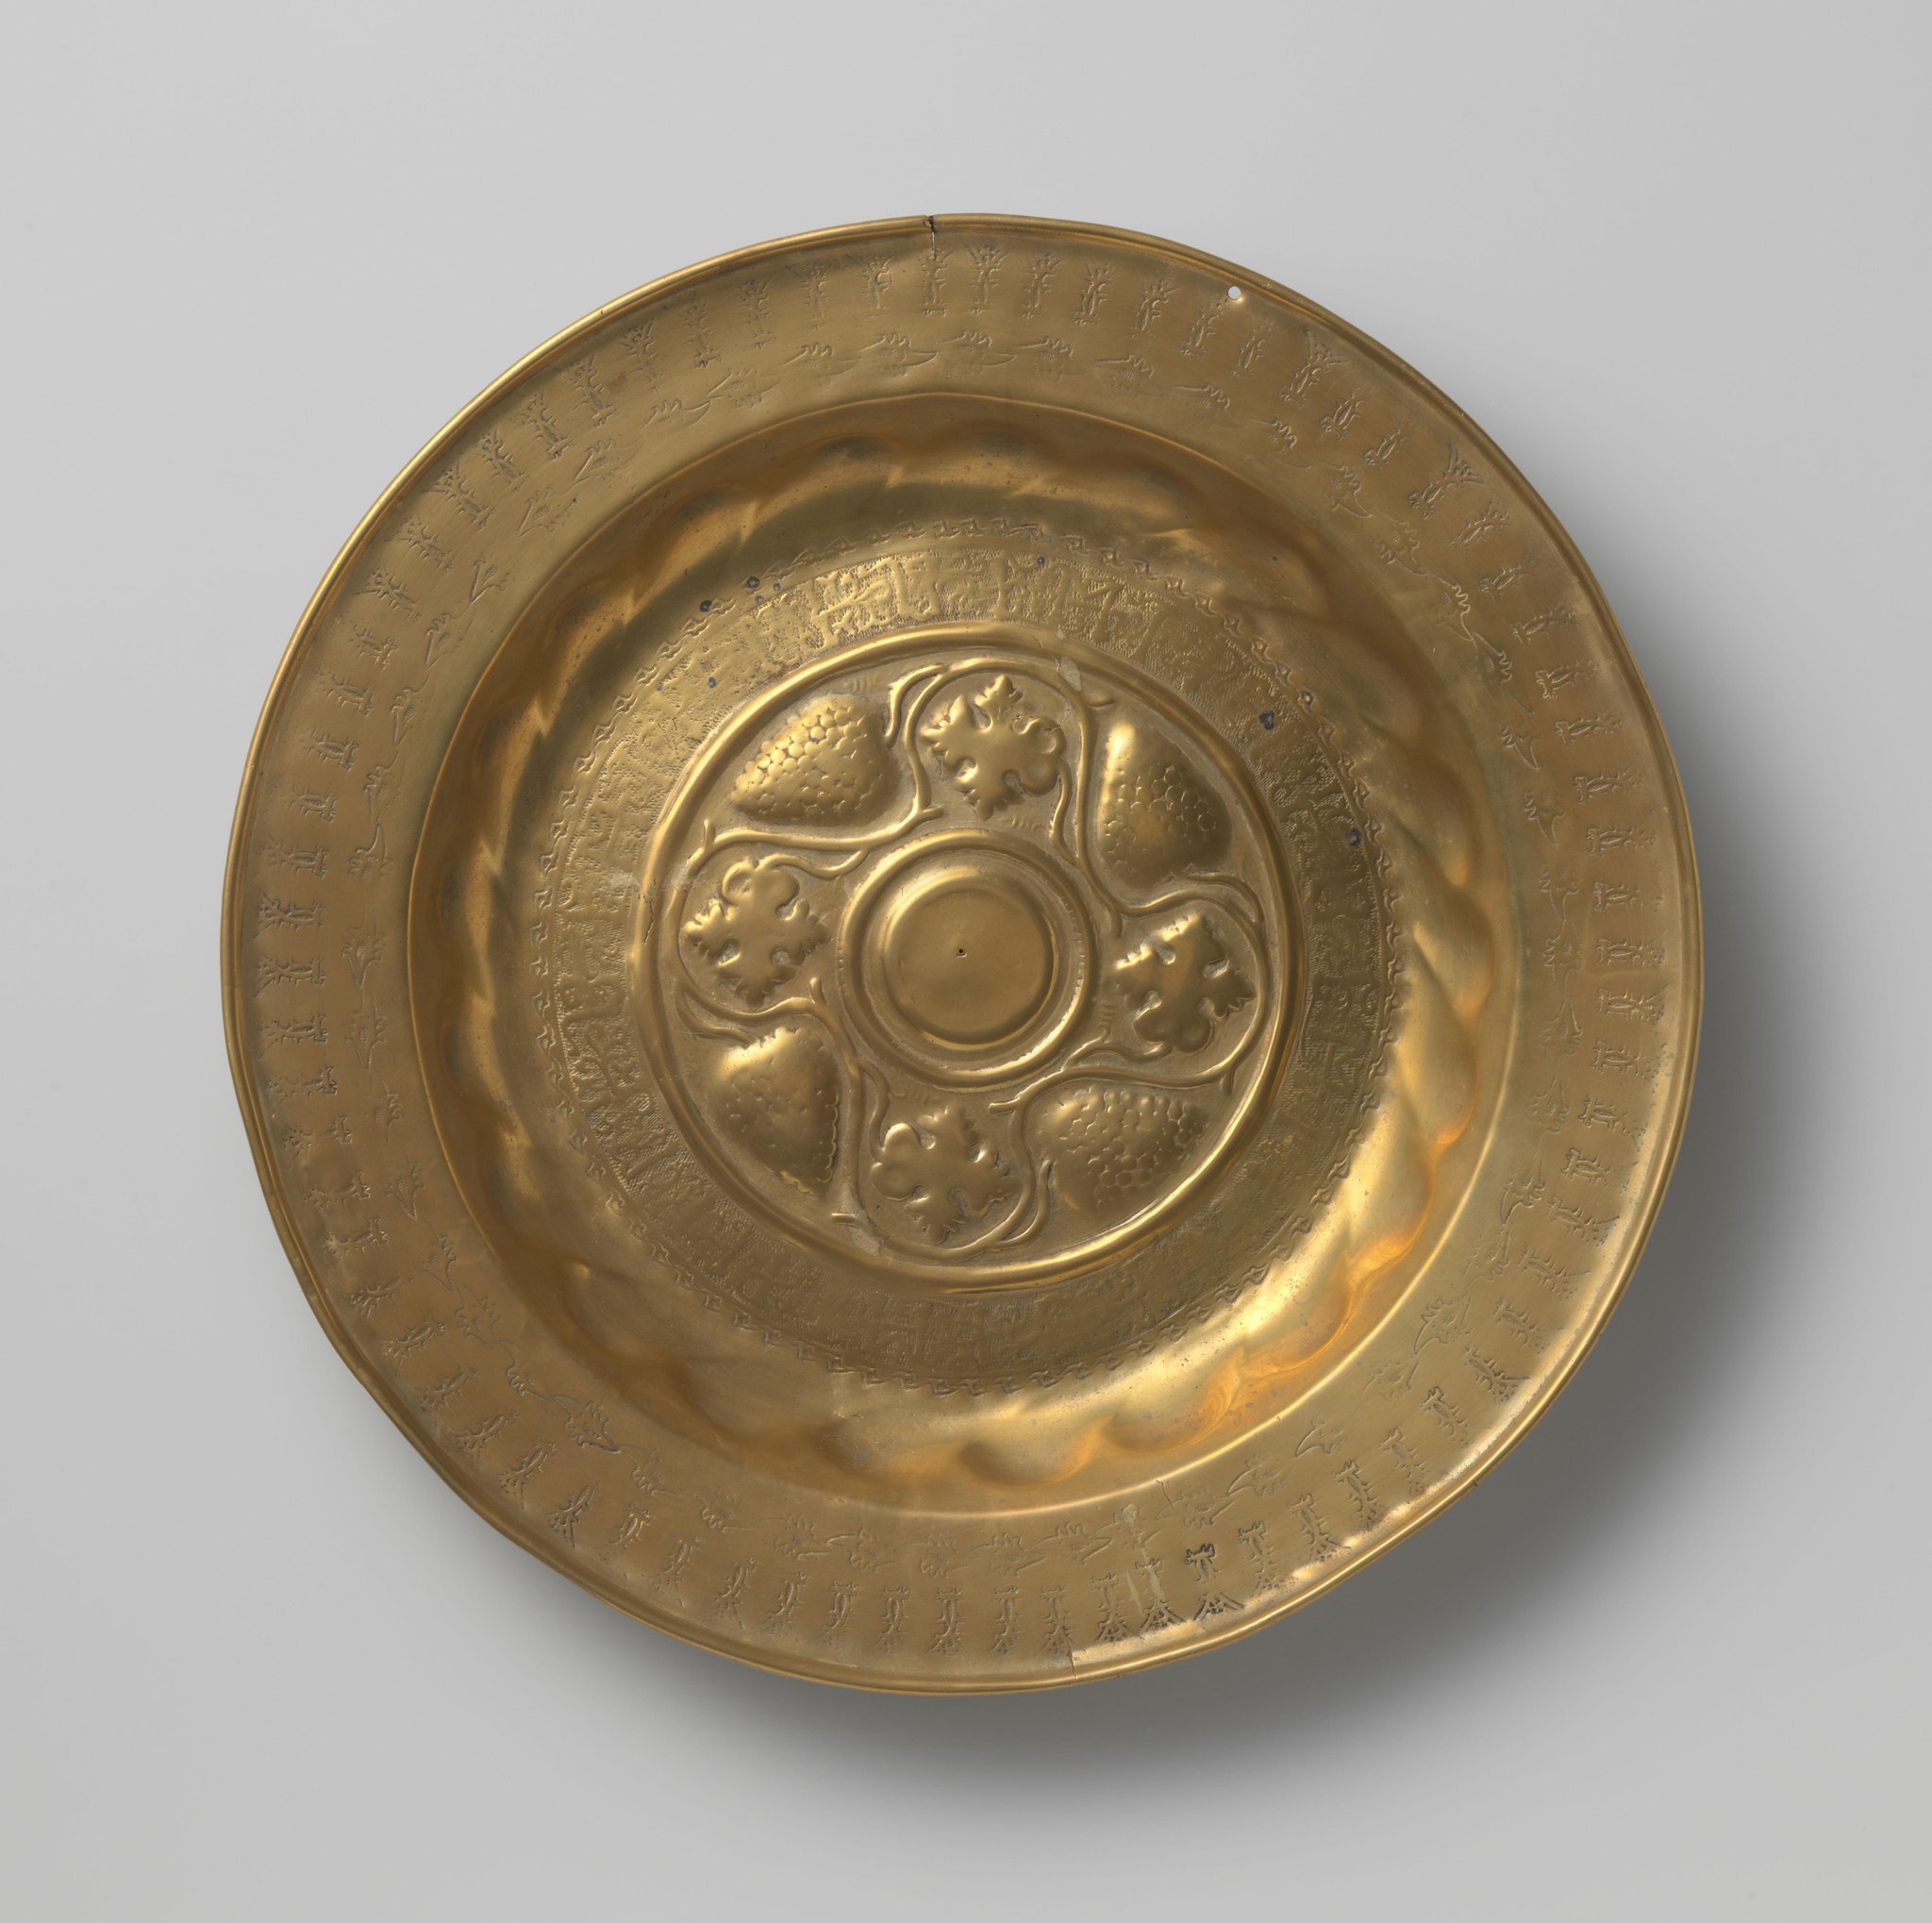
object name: platter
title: Schotel met druiventrossen en wingerdbladeren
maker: Anonymous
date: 1500-1600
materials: brass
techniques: casting, punching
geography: nuremberg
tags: vine-tendril, leaf, bunch of grapes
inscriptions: inscription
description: In het plat van de schotel, die in het midden het centerpunt heeft, zijn met behulp van stempelvormen geponst: een umbo omgeven door rankwerk met vier druiventrossen en vier wingerdbladeren, alsmede een rand van willekeurige letters op gearceerde achtergrond (vier maal herhaald). Verder is op de boord een geponst ornament aangebracht van gestileerde bladmotieven in het midden en van takken langs de rand. In de wand zijn visblazen gedreven. De rand is om ijzerdraad geslagen. De hangring aan de achterzijde en het gat in de rand zijn later aangebracht. Het centerpunt is een kleine opening geworden.